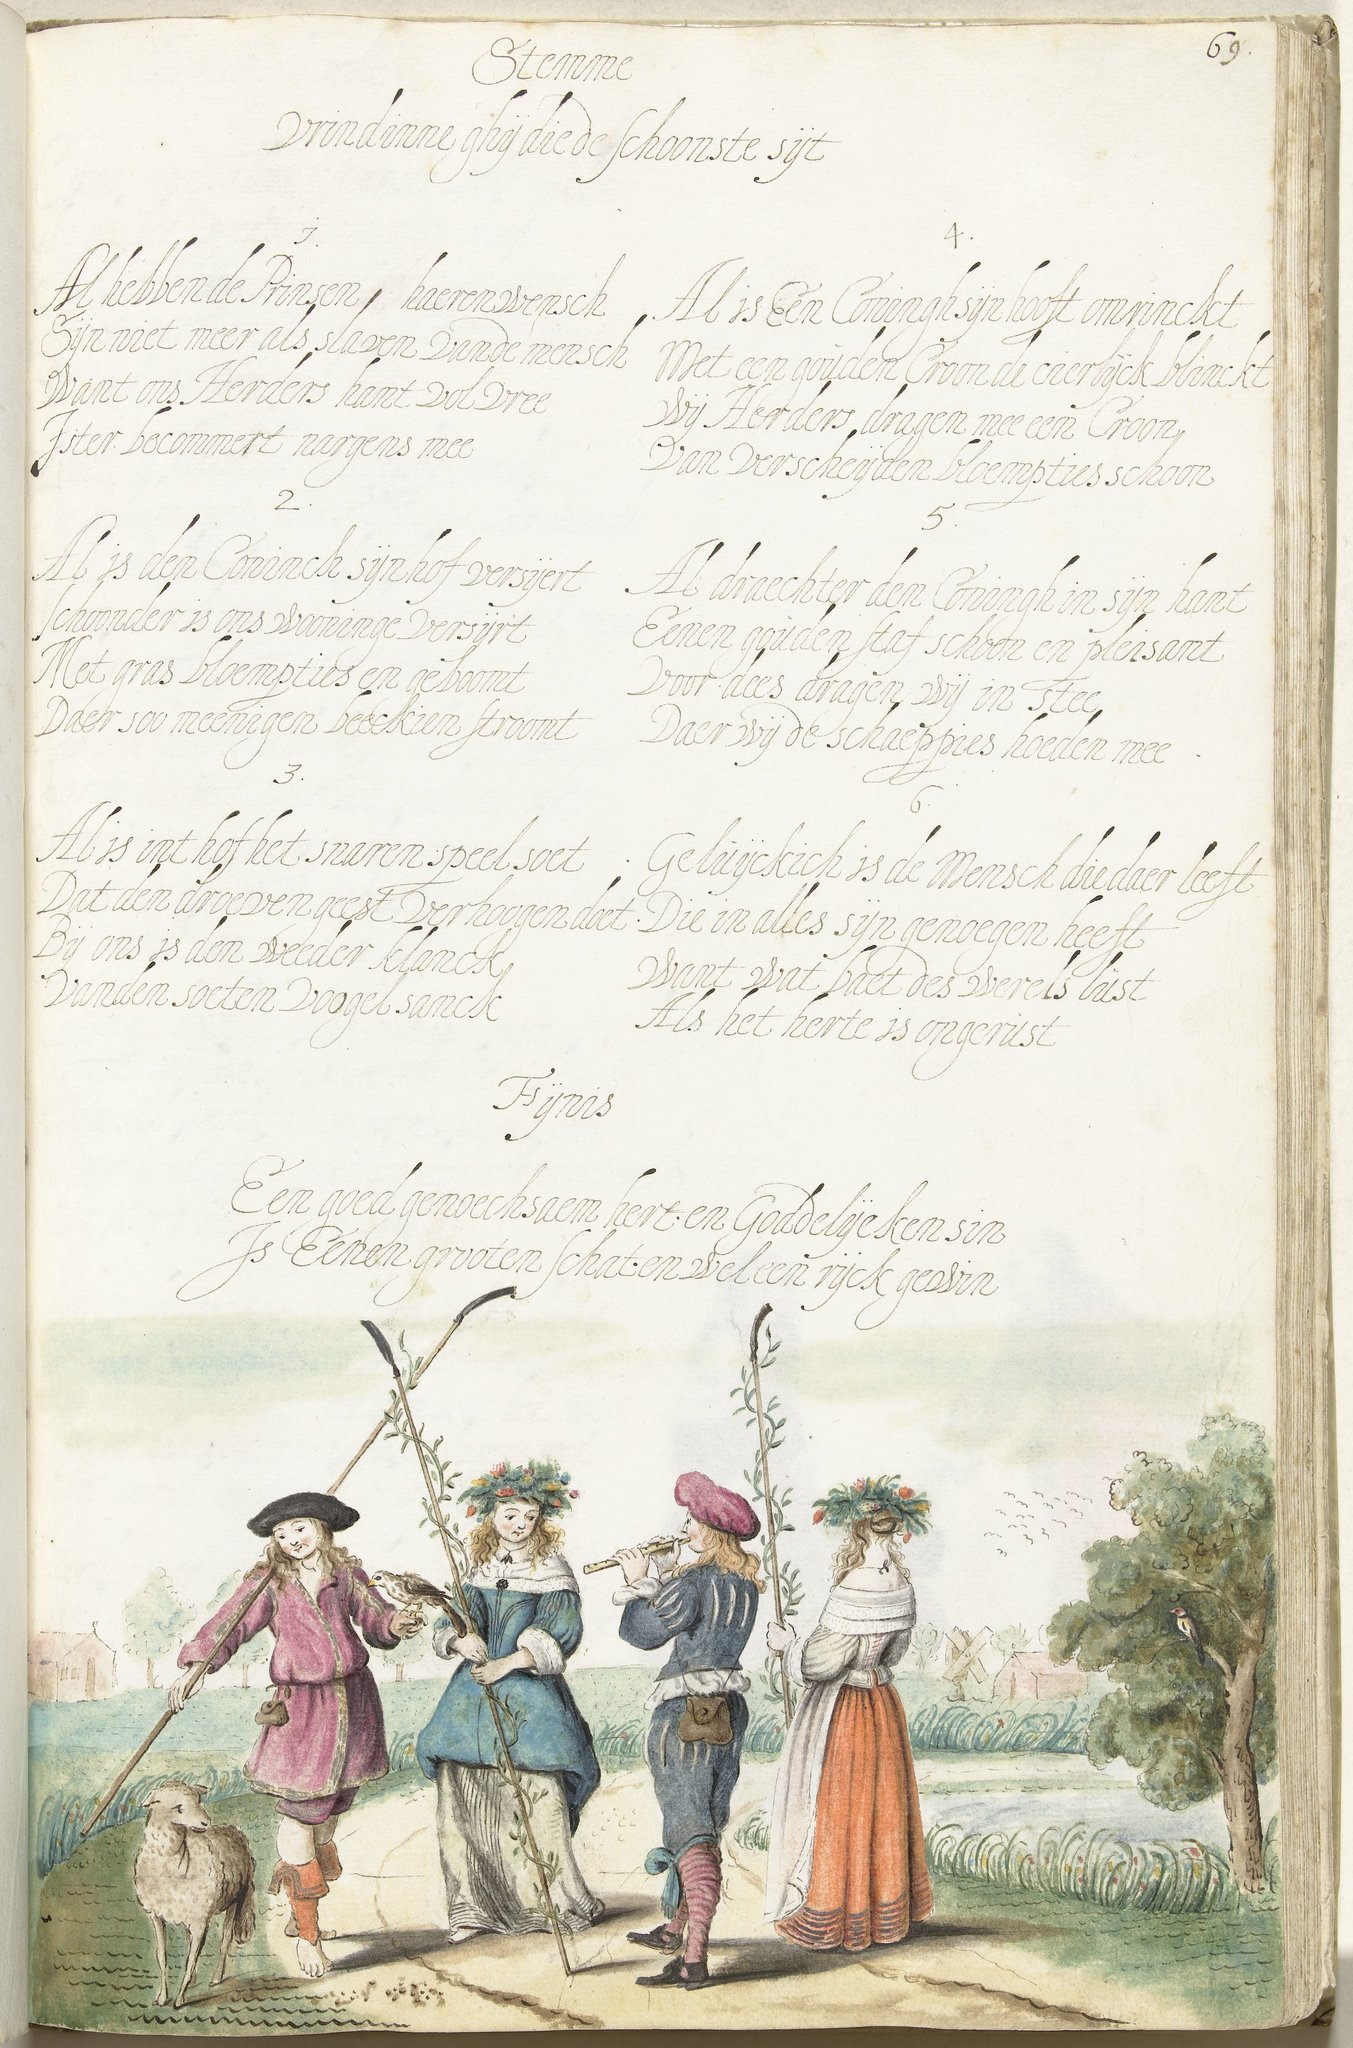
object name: calligraphy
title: Vier pastorale figuren in een landschap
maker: gesina ter borch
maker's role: draughtsman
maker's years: 1633-1690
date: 1654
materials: ink, paper, watercolor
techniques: brush, calligraphy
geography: zwolle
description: Vier pastorale figuren in een landschap onder een gedicht op de melodie van Vrindinne, ghij die de schoonste sijt. Het gedicht gaat over het contrast tussen de luxe aan het hof en de pastorale eenvoud. Onderaan heeft Gesina twee regels toegevoegd.